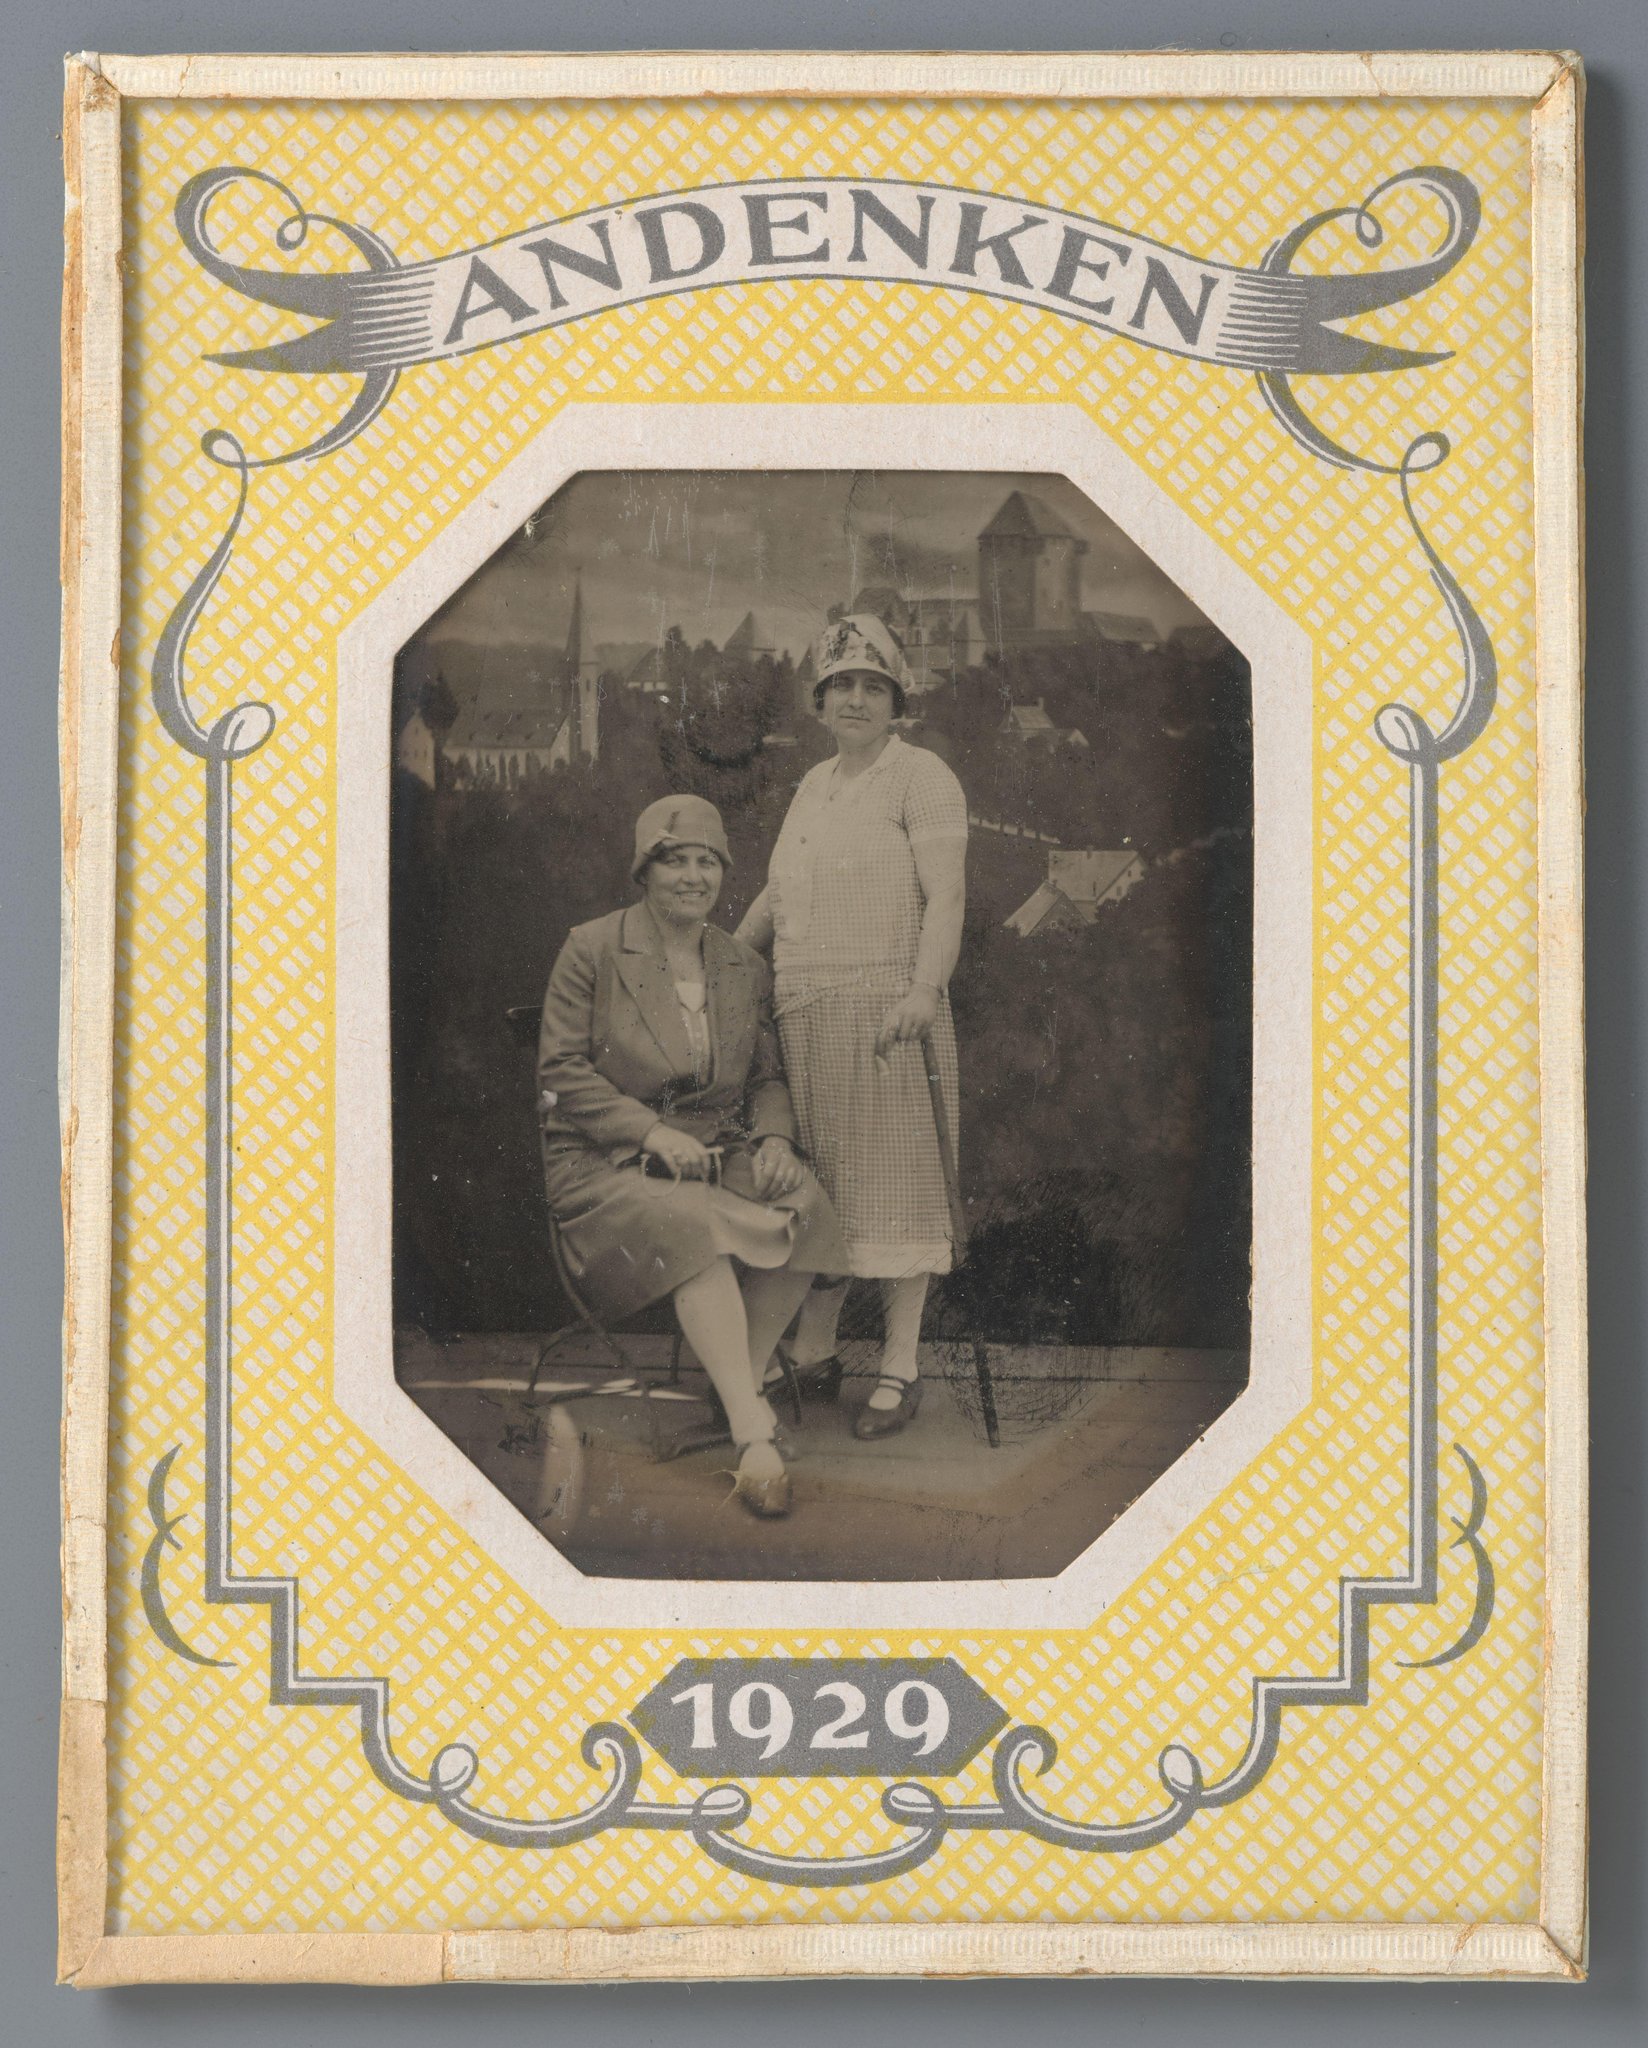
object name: photograph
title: Portrait of two unknown women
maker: Anonymous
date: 1929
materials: cardboard, glass, iron, paper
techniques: ferrotyping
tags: historical persons - bb - woman, adult woman (+ two persons)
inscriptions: date